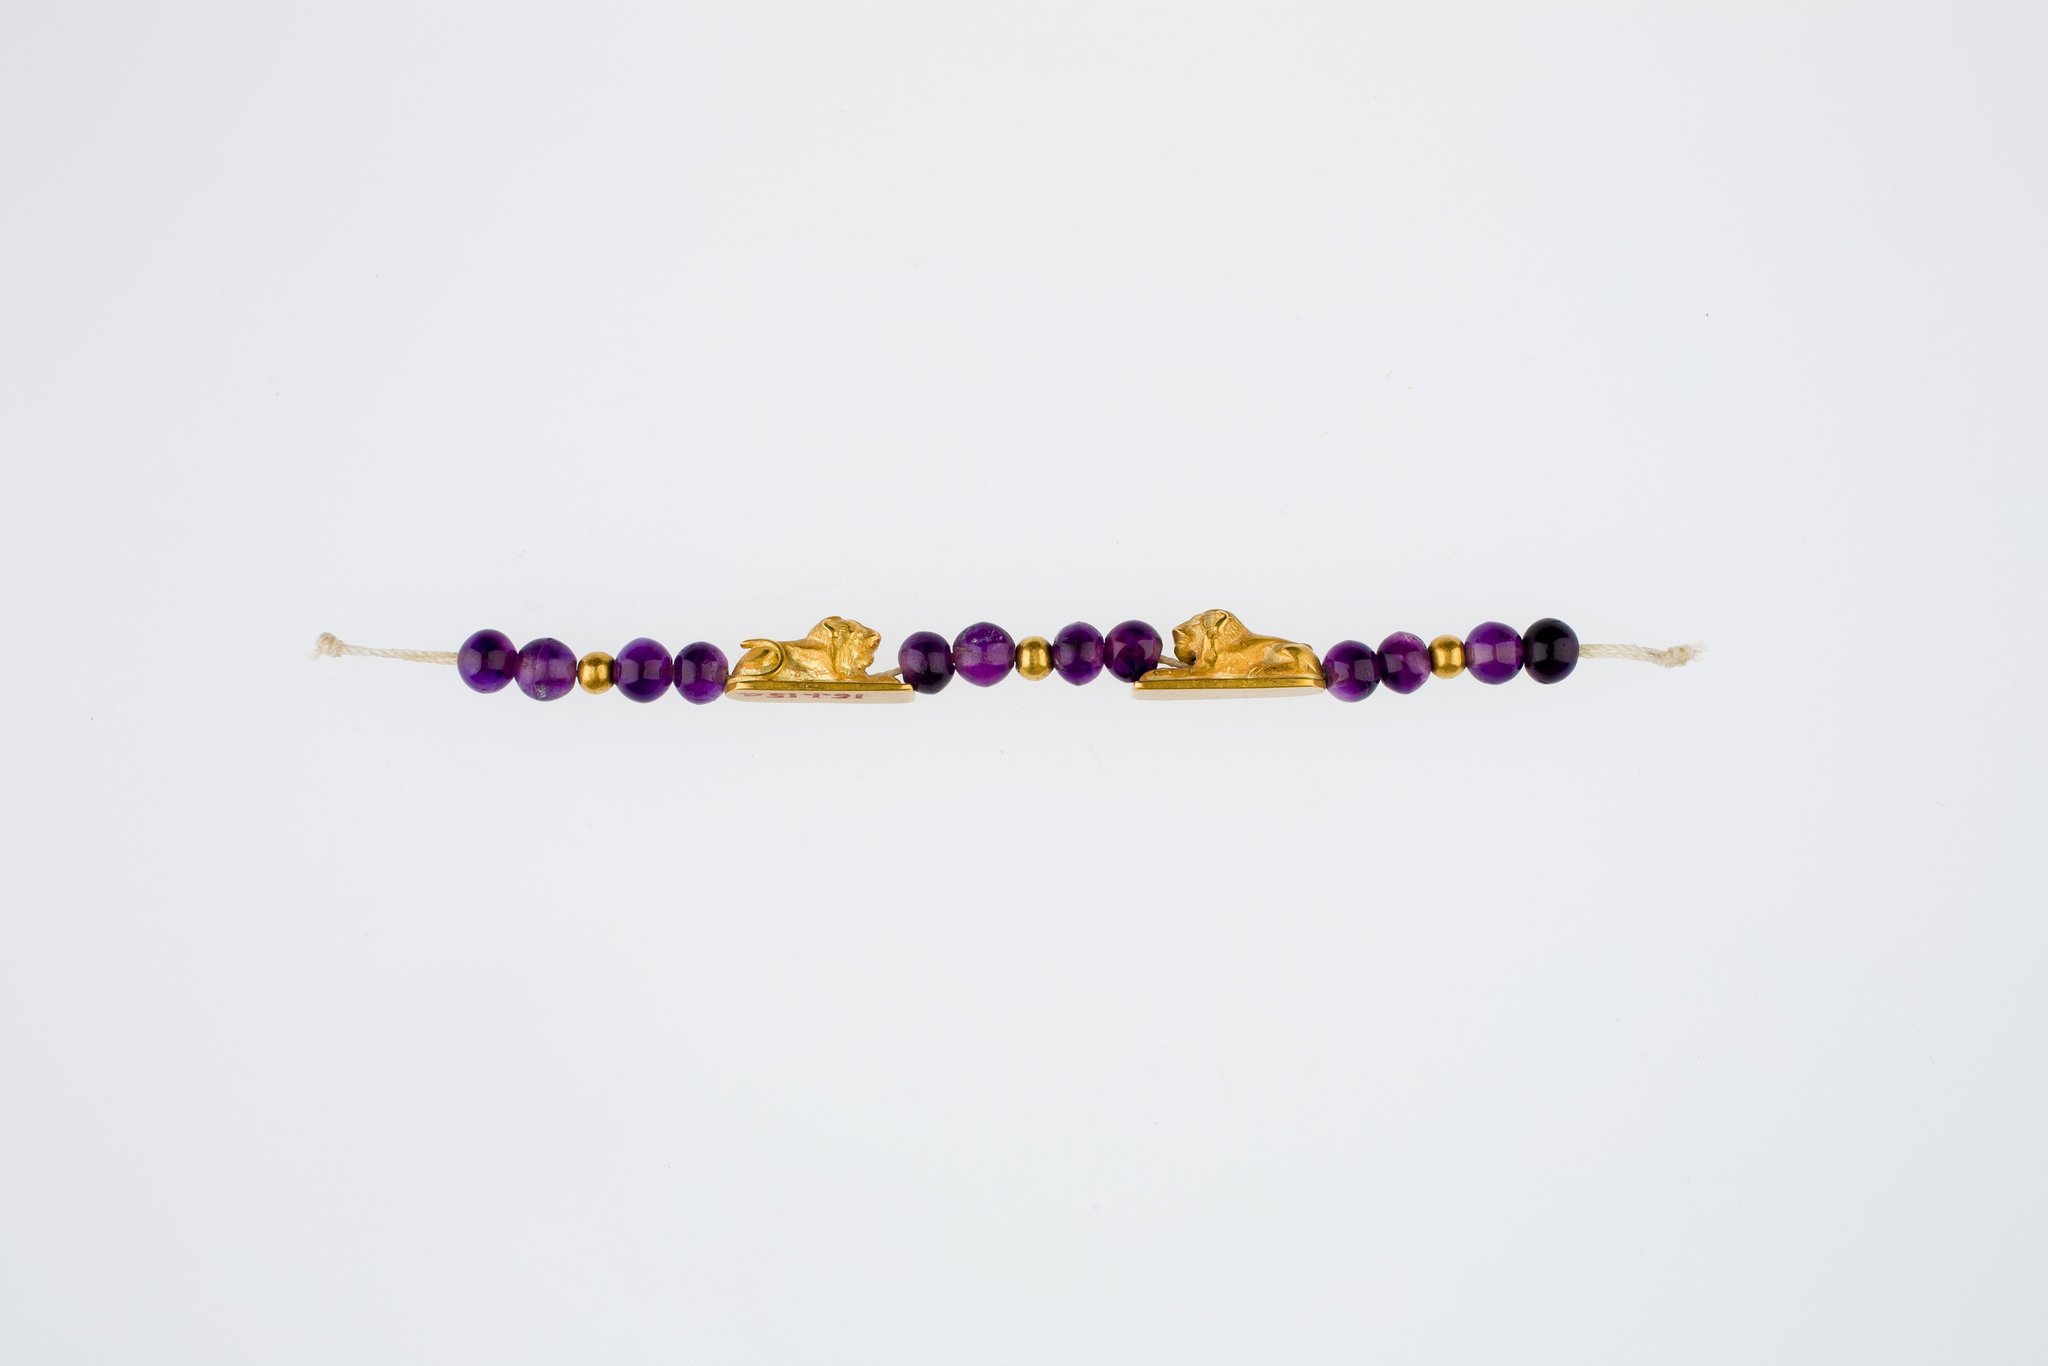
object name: bracelet, sithathoryunet, lion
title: Lion Bracelet of Sithathoryunet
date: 1887-1813 BCE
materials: gemstone, gold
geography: egypt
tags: lions